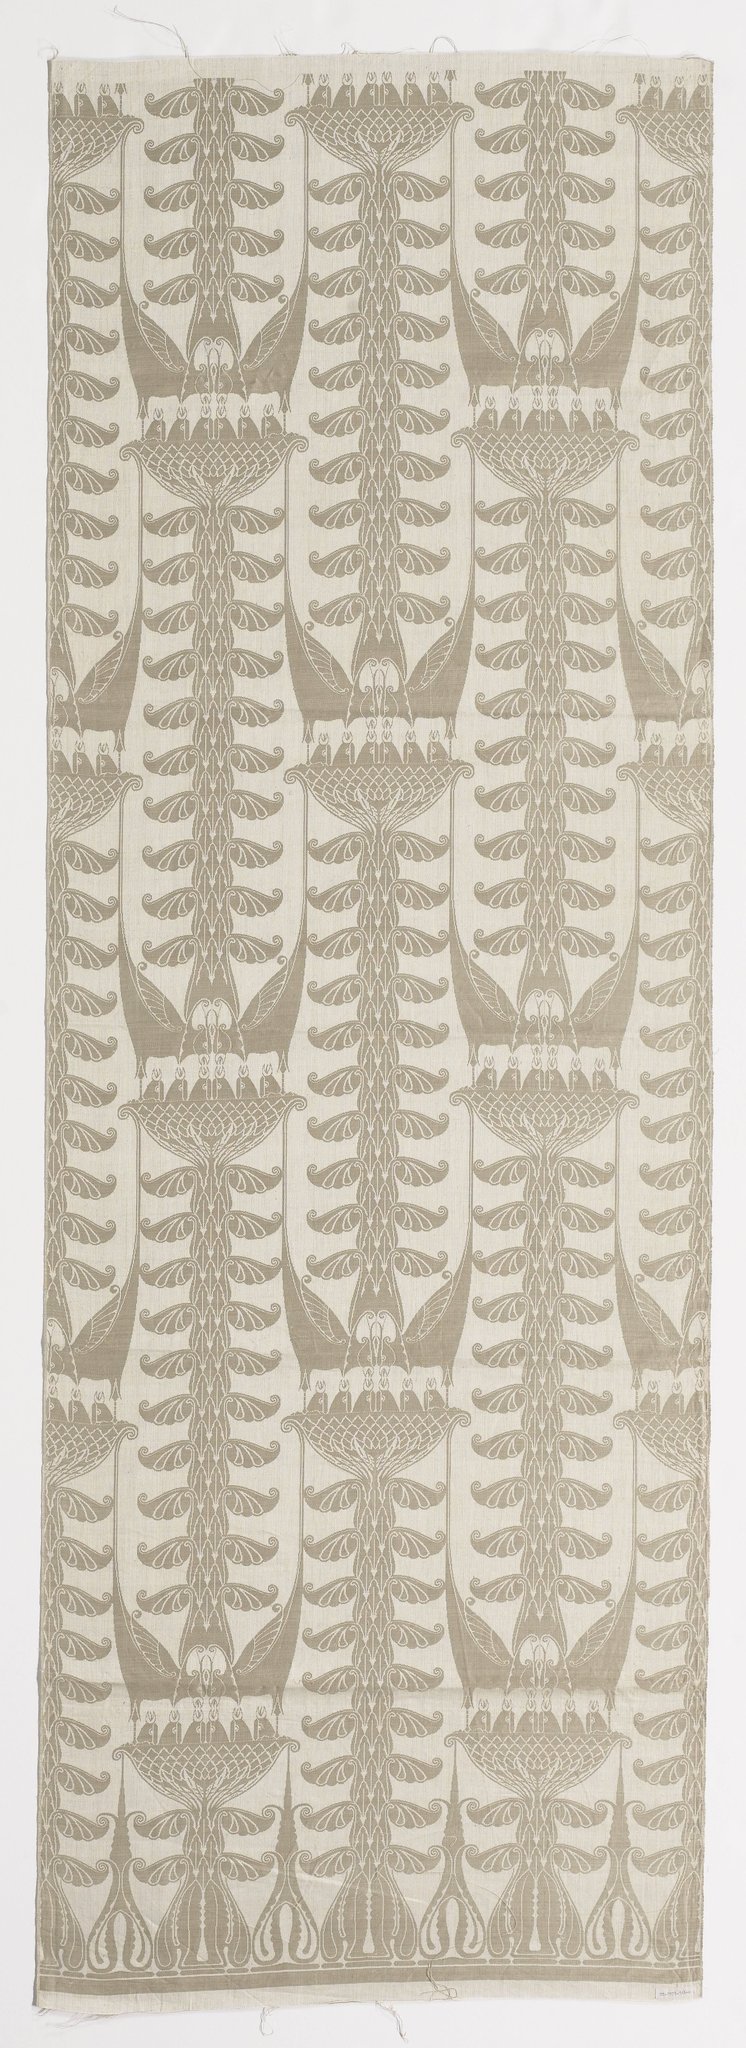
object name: upholstered wall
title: Wandbespanning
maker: chris lebeau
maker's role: draughtsman, print maker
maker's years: 1878-1945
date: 1911-1915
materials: linen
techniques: damask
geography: eindhoven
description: Beige-grijze damasten wandbespanning met een dessin van vogelnesten.